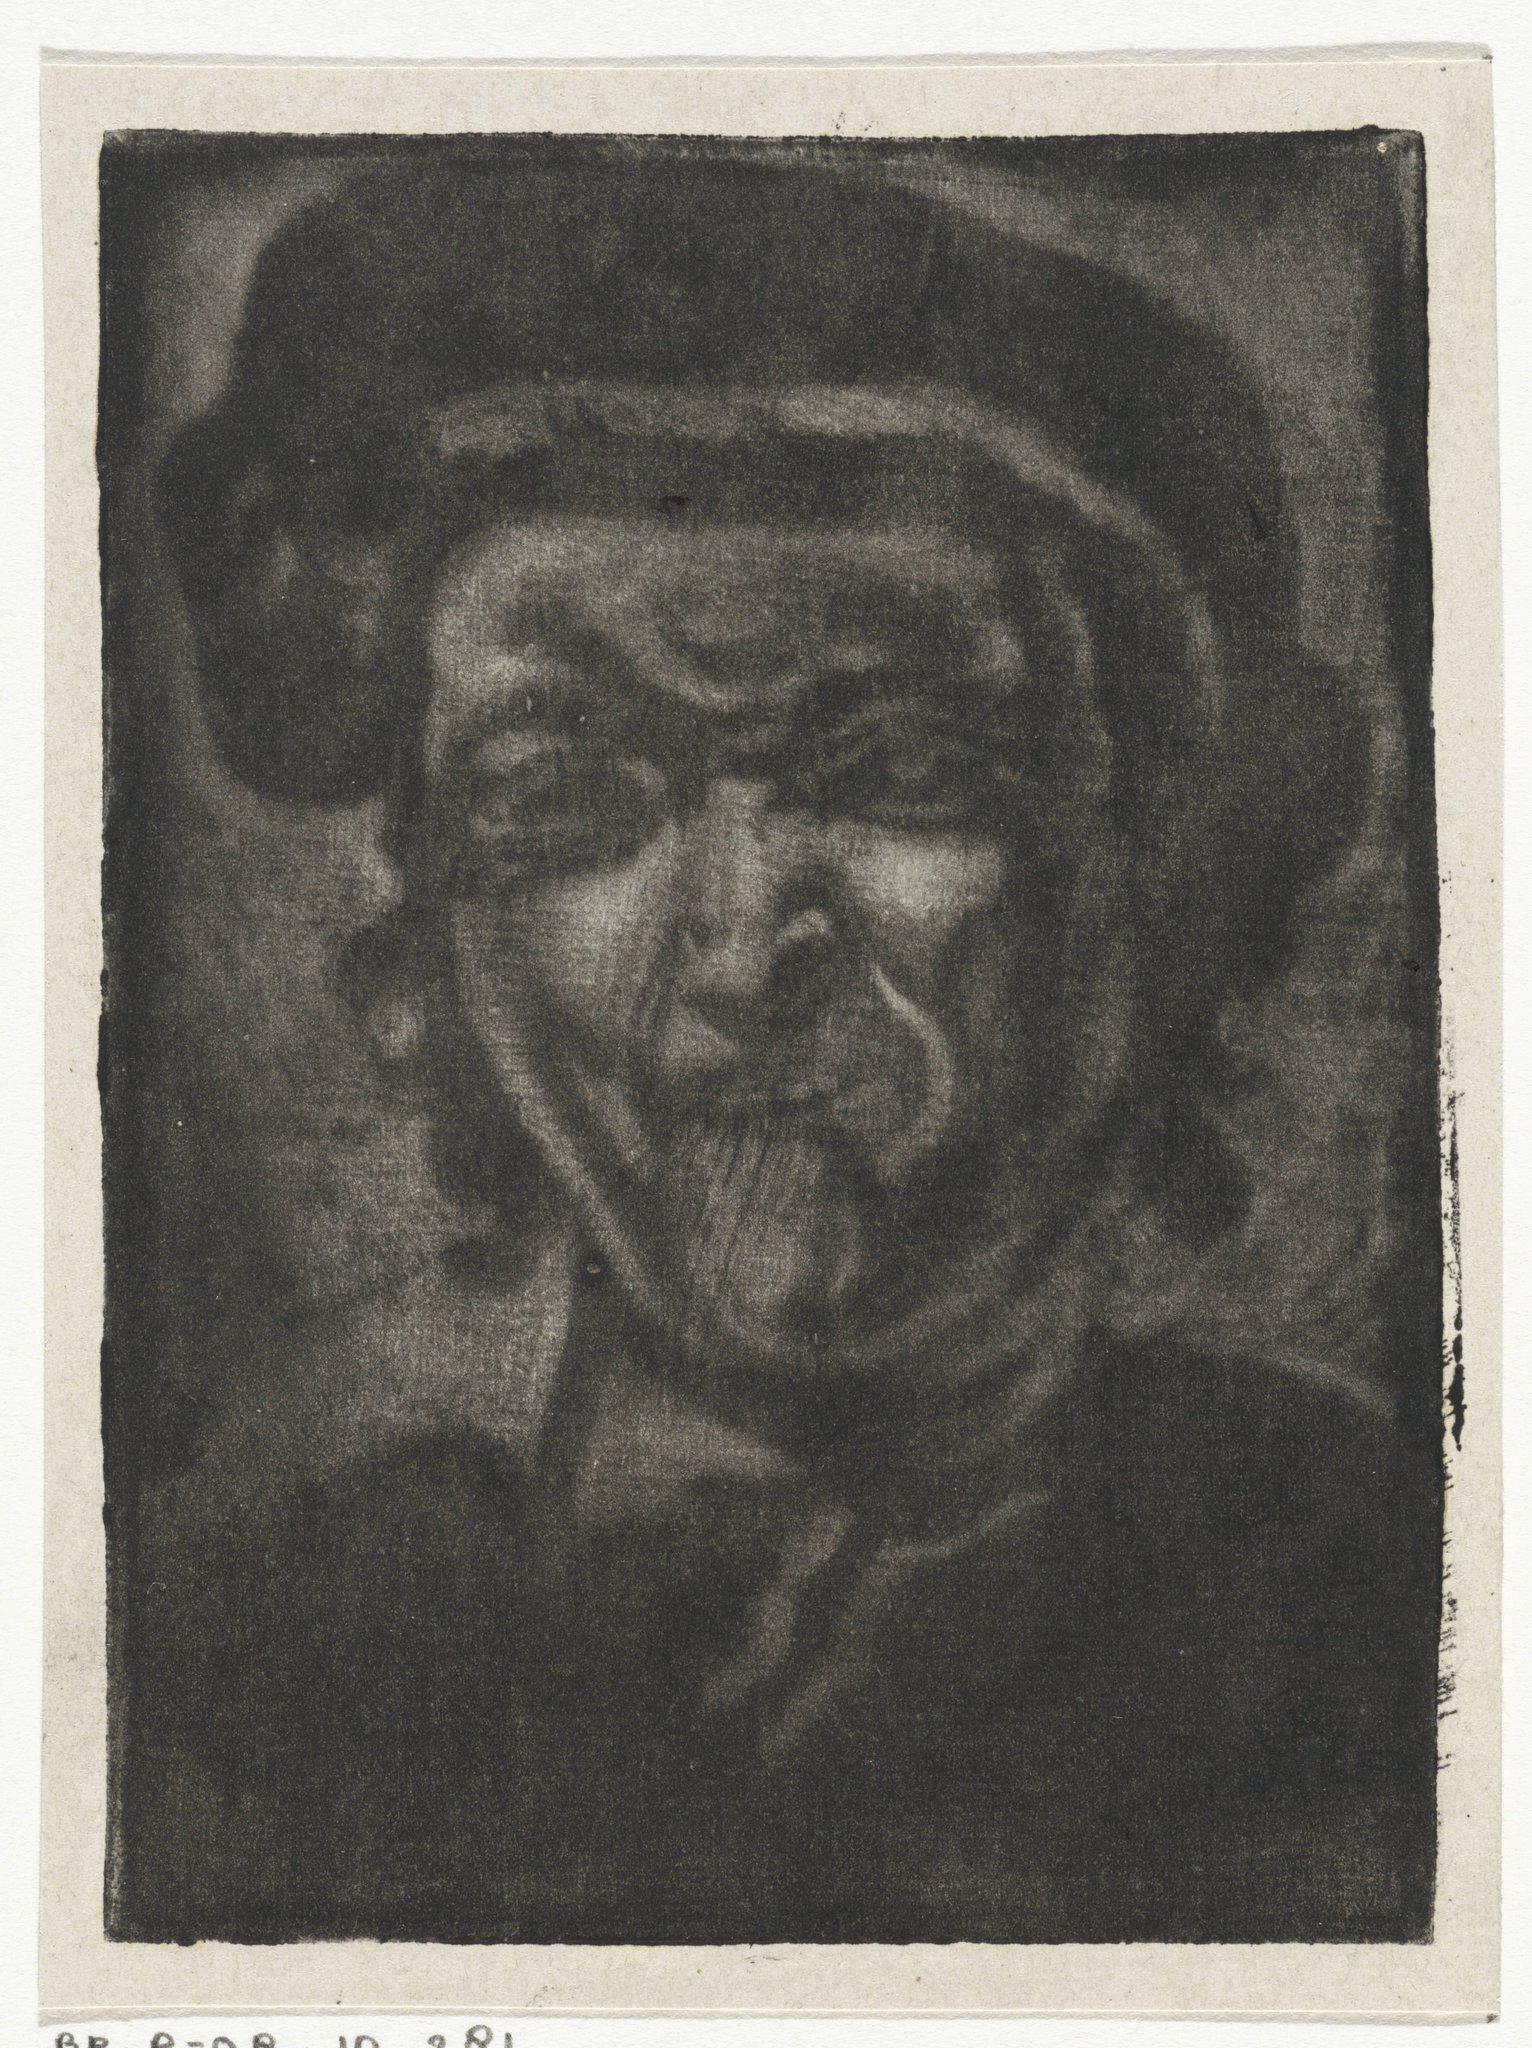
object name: print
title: Man met een vertrokken gezicht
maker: eberhard cornelis rahms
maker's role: print maker, publisher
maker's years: 1823-1907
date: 1854-1907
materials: paper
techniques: mezzotint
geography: netherlands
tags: head-gear: cap (+ men's clothes), grimacing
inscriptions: collector's mark: Lugt 2228